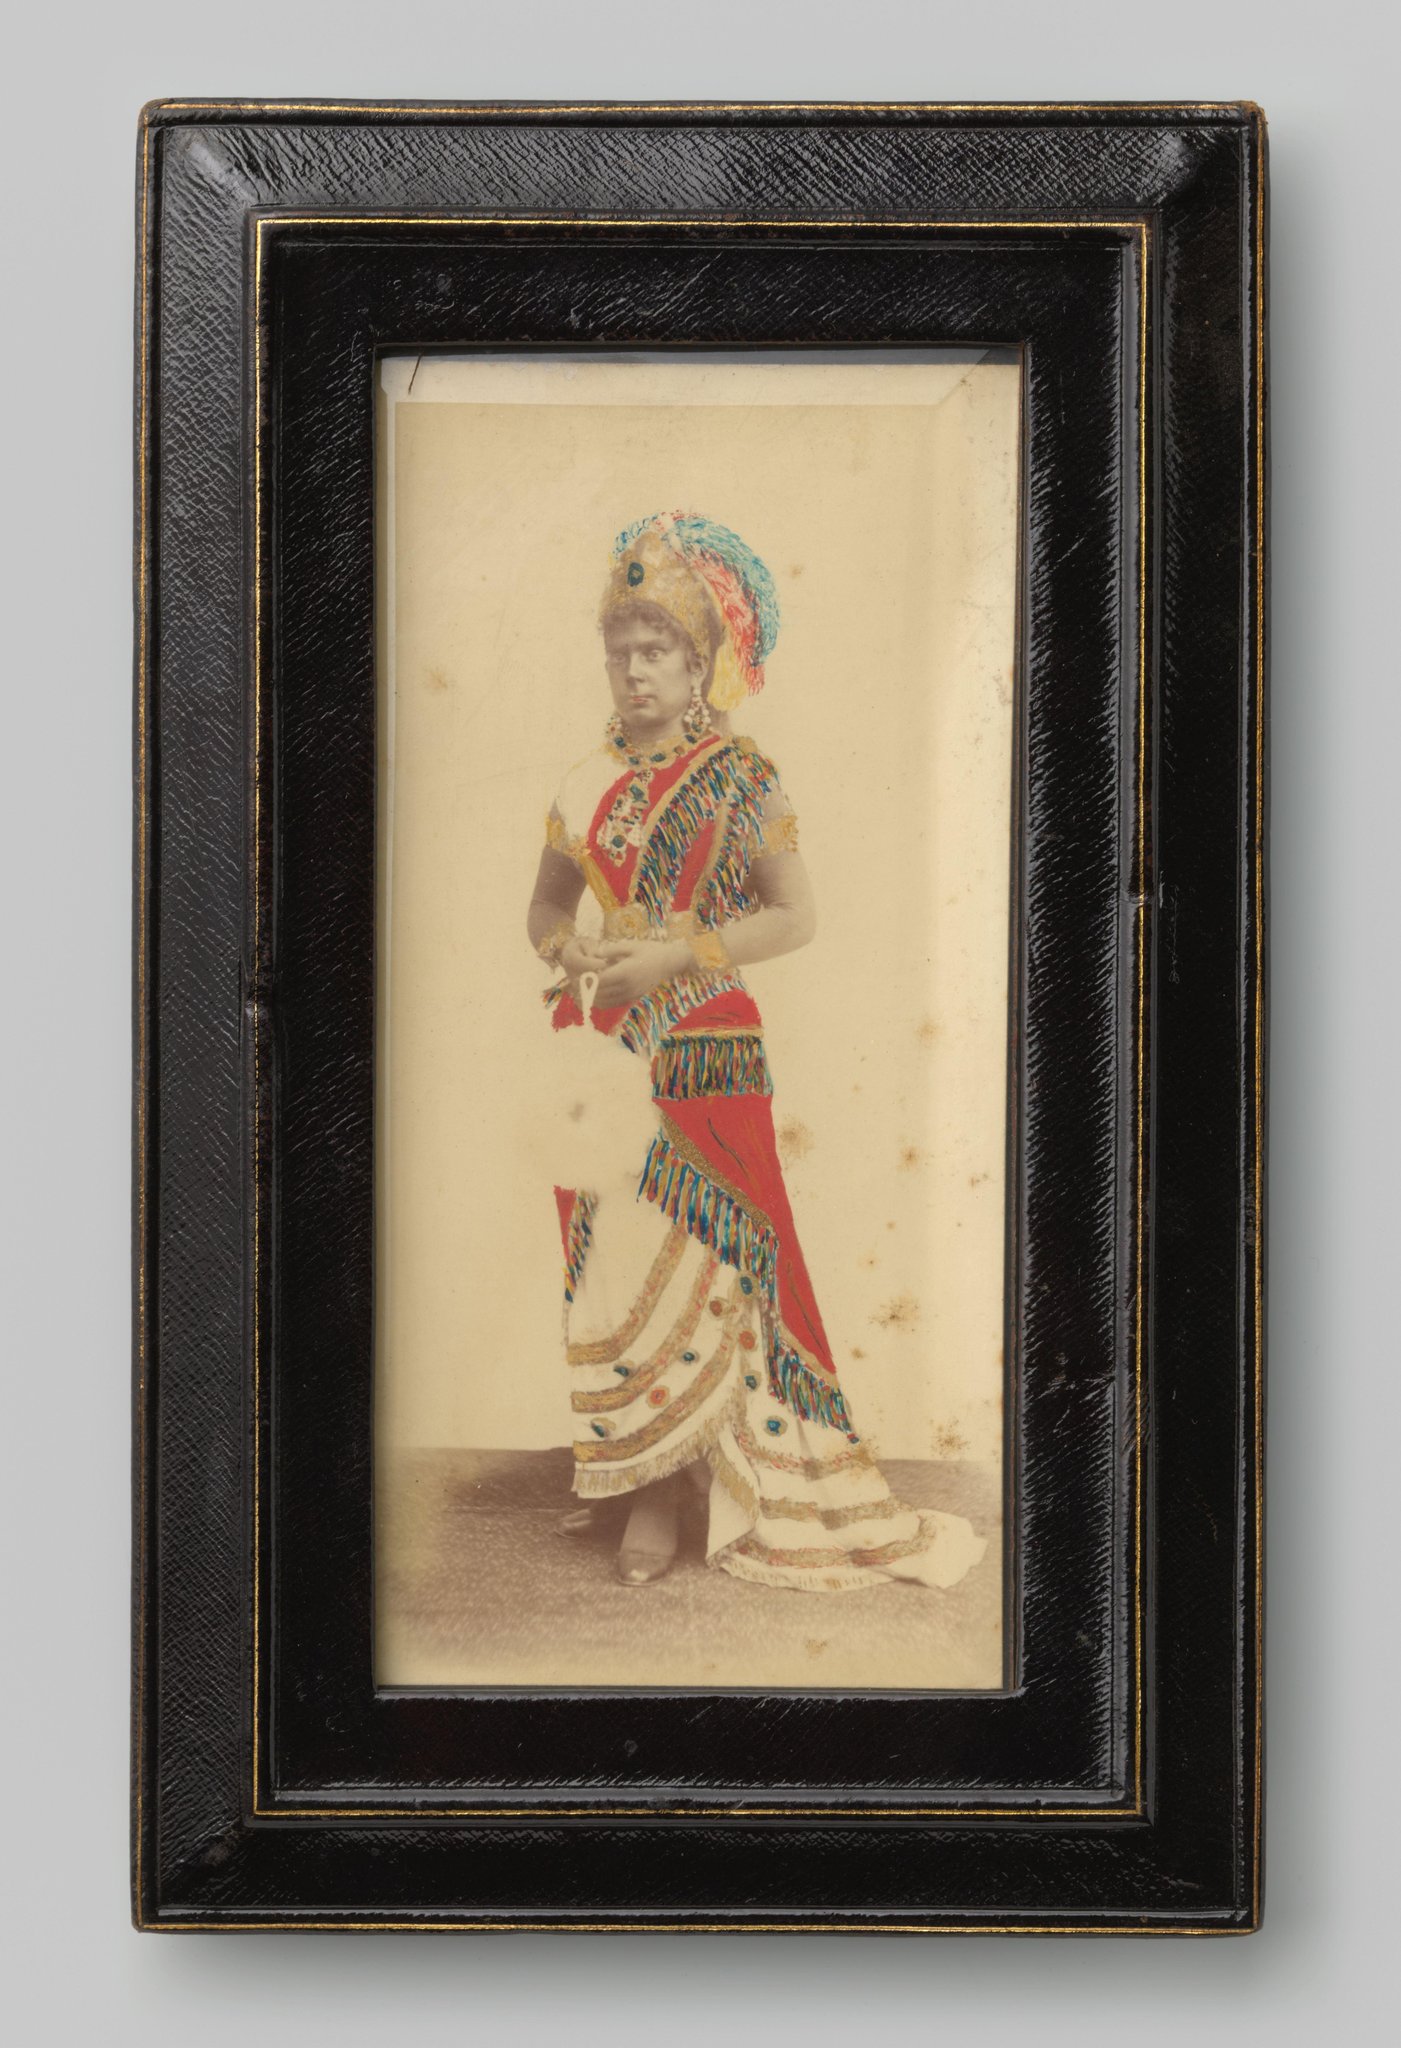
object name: frame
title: Portret van een vrouw in kostuum, aangeduid als Valeria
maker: juan martí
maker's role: fotograaf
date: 1870-1920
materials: cardboard, glass, metal, paper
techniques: albumen print, hand coloring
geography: barcelona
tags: portrait of actor, actress